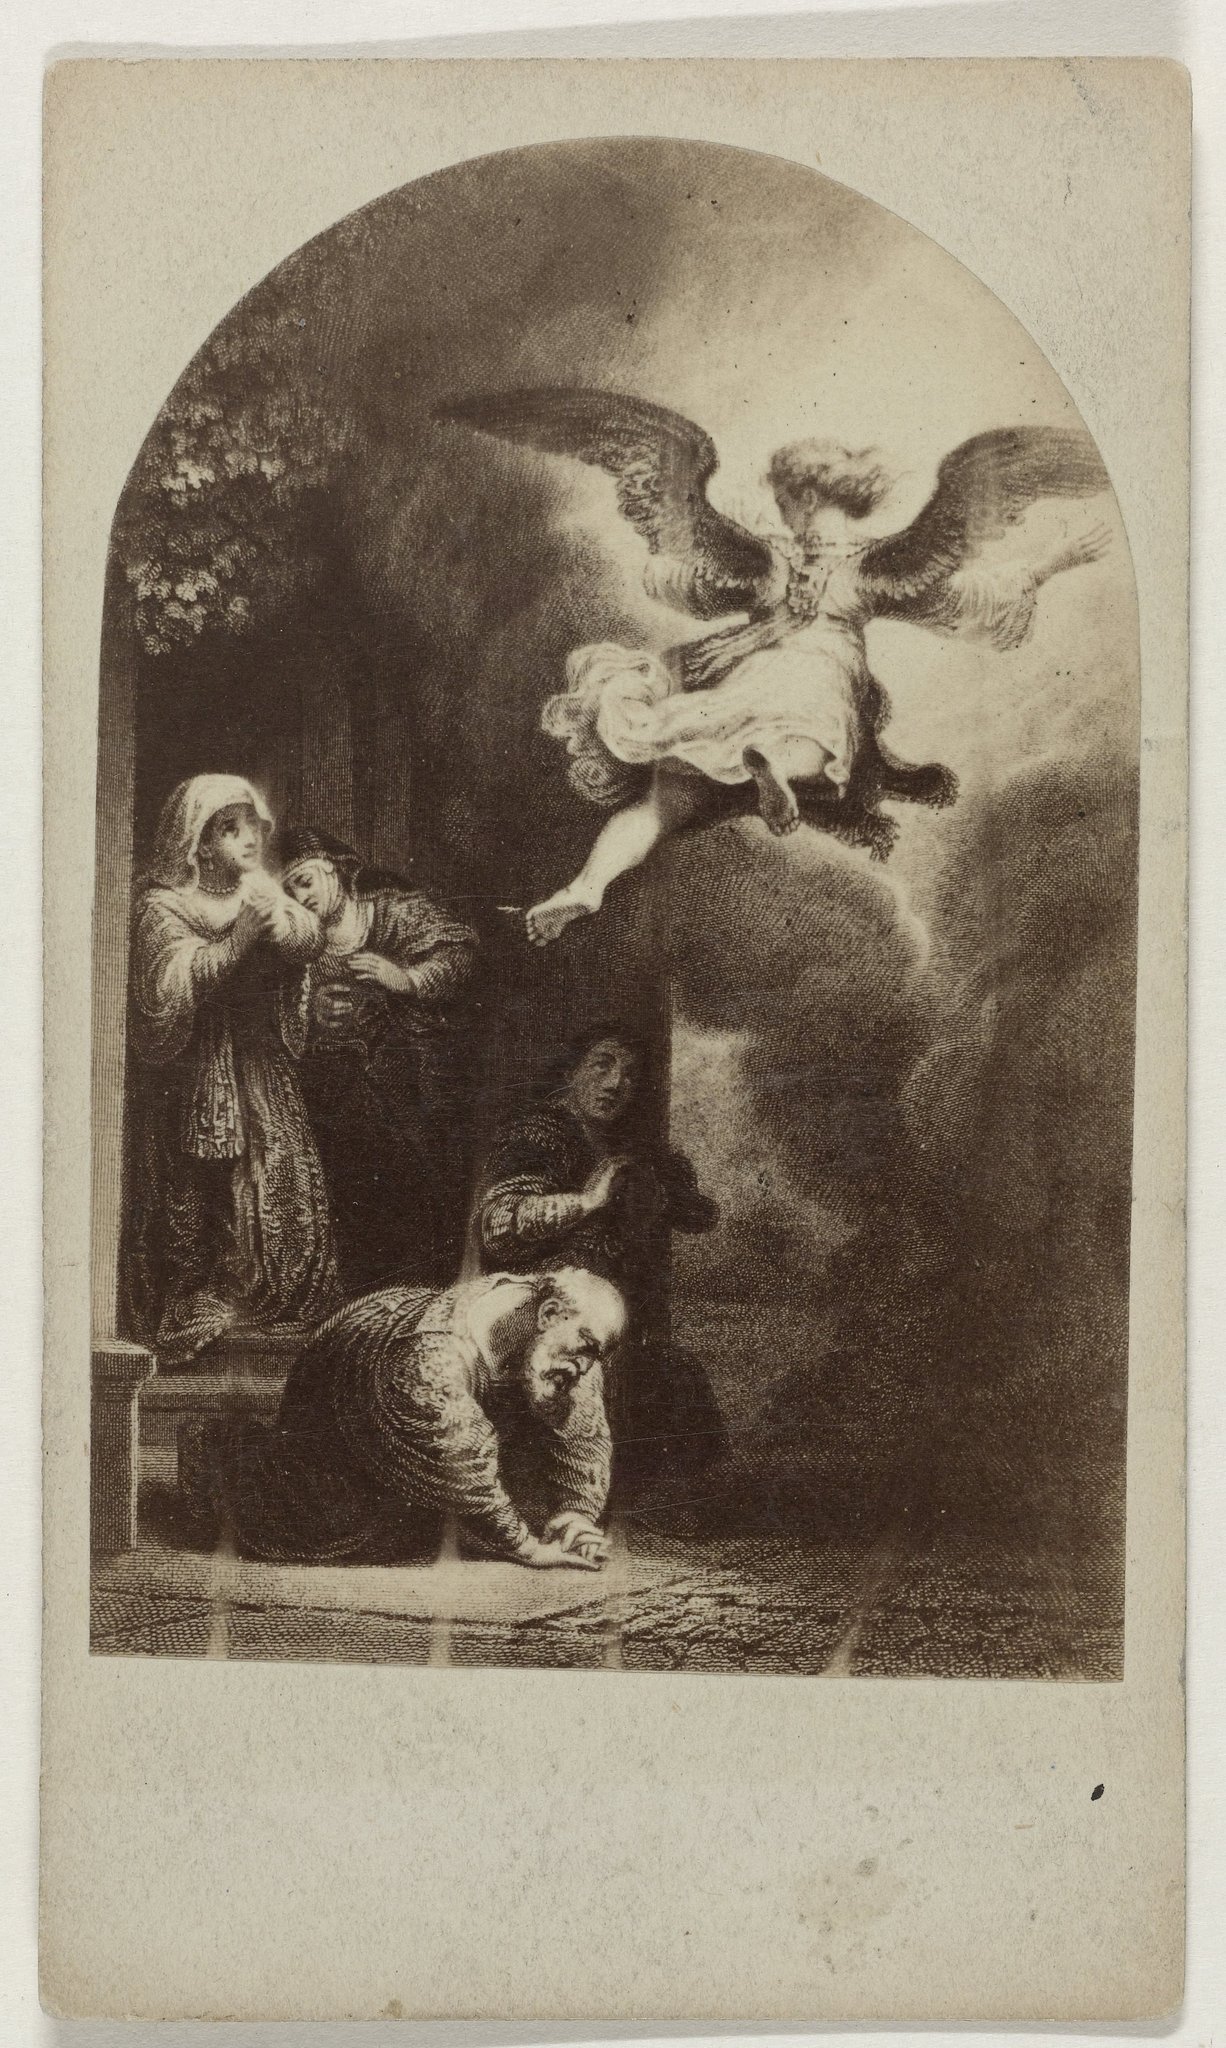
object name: carte de visite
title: De engel verlaat het huis van de familie van Tobias.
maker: Anonymous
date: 1860-1865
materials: cardboard, paper, photographic support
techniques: albumen print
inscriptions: annotation: ‘familie tobie/rembrandt’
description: Foto van een kopie naar het schilderij van Rembrandt uit 1637dat zich in het Louvre bevindt.